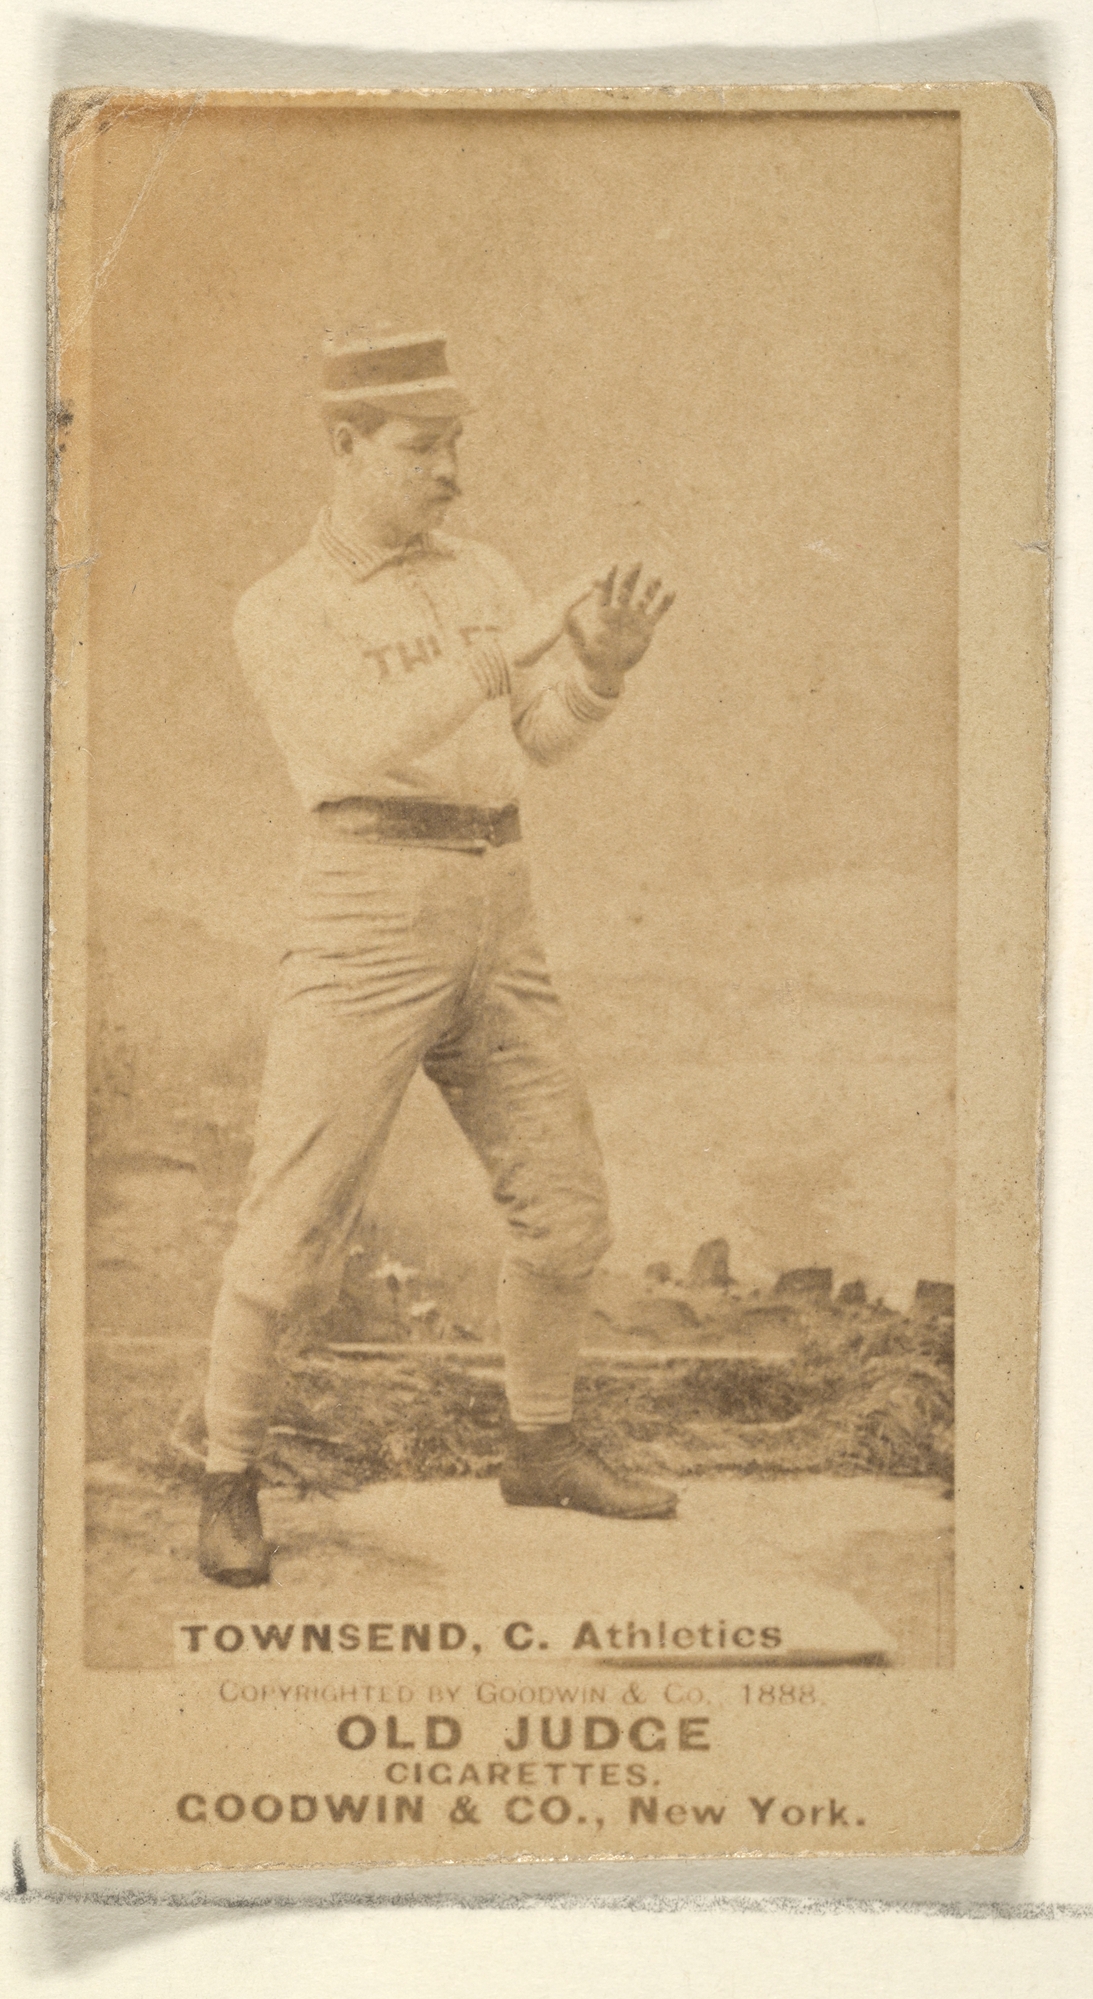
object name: baseball card, photograph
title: Townsend, Catcher, Philadelphia Athletics, from the Old Judge series (N172) for Old Judge Cigarettes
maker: goodwin & company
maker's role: publisher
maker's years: 1850-1950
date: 1888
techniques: albumen silver print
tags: men,portraits,baseball,athletes